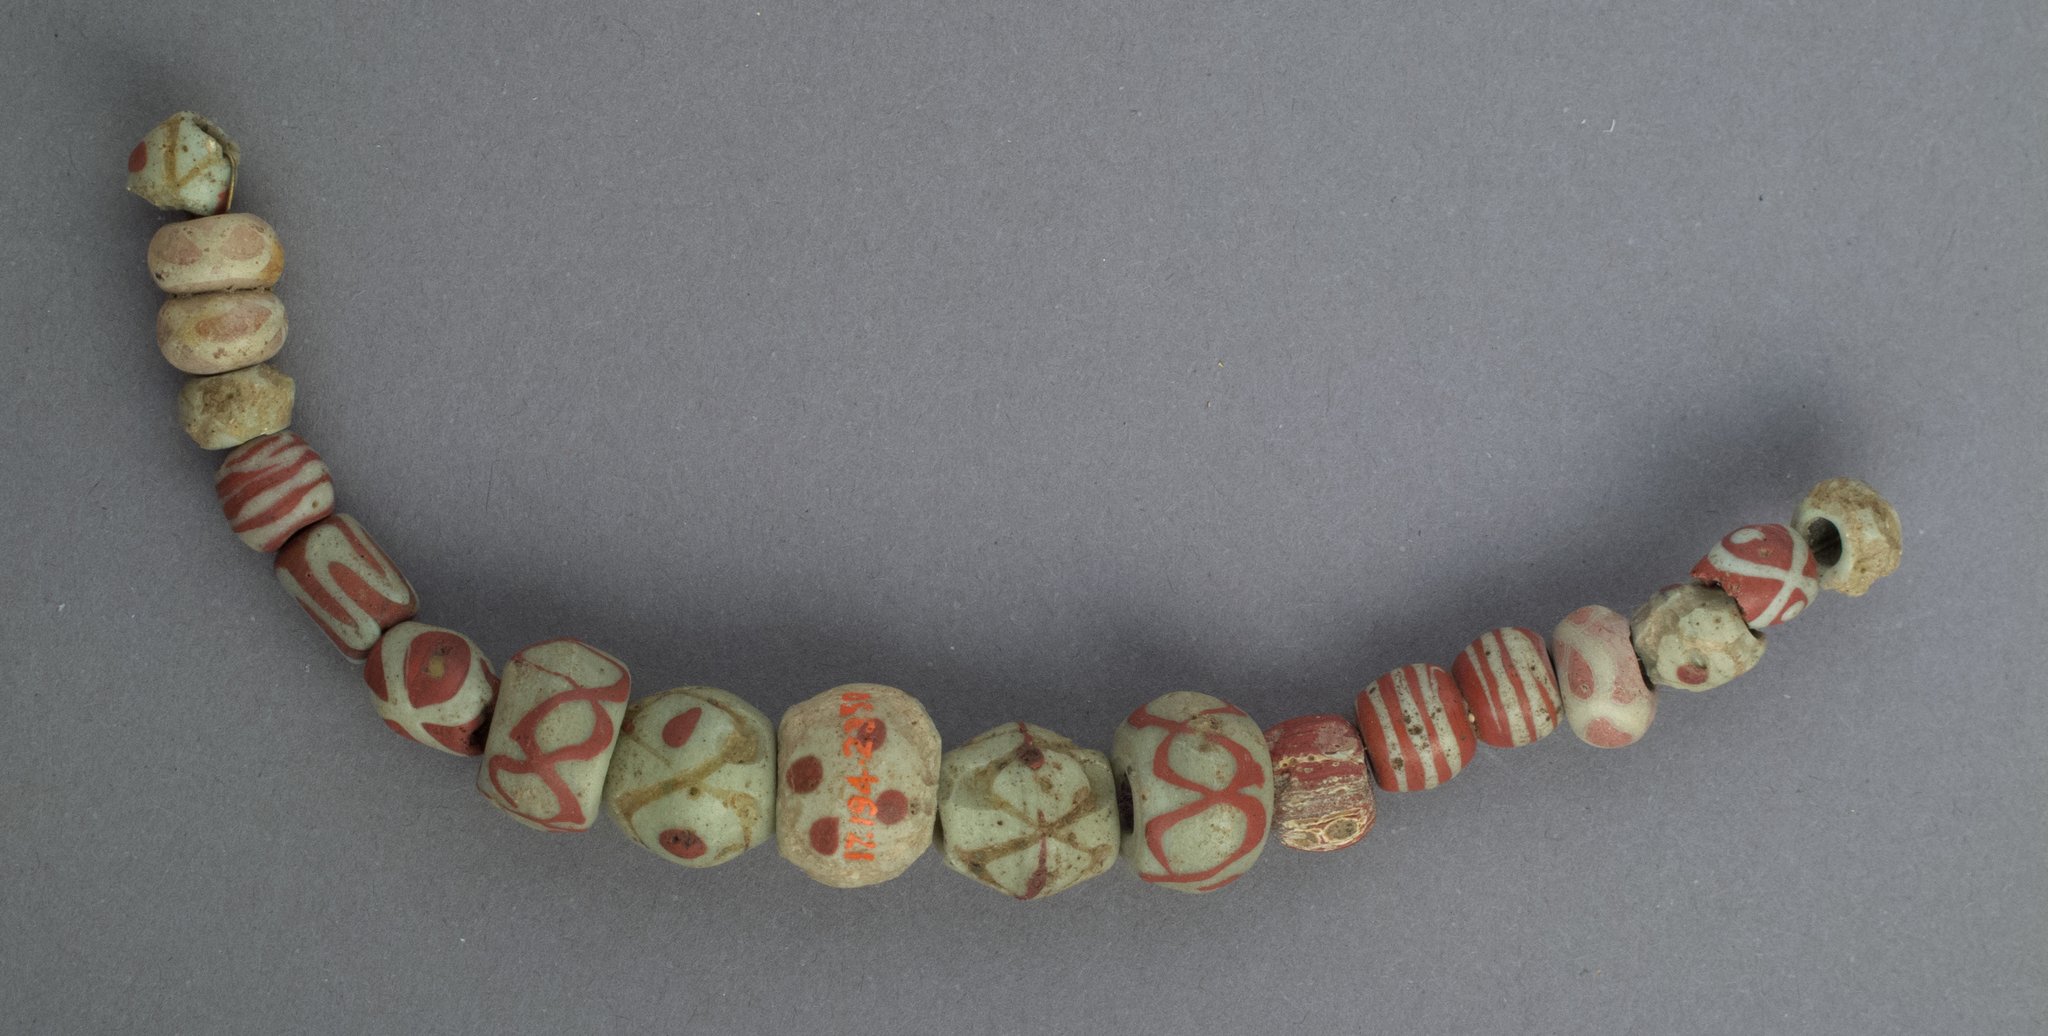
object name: bead, 19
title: Beads, 19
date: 7000 BCE-330 CE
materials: glass